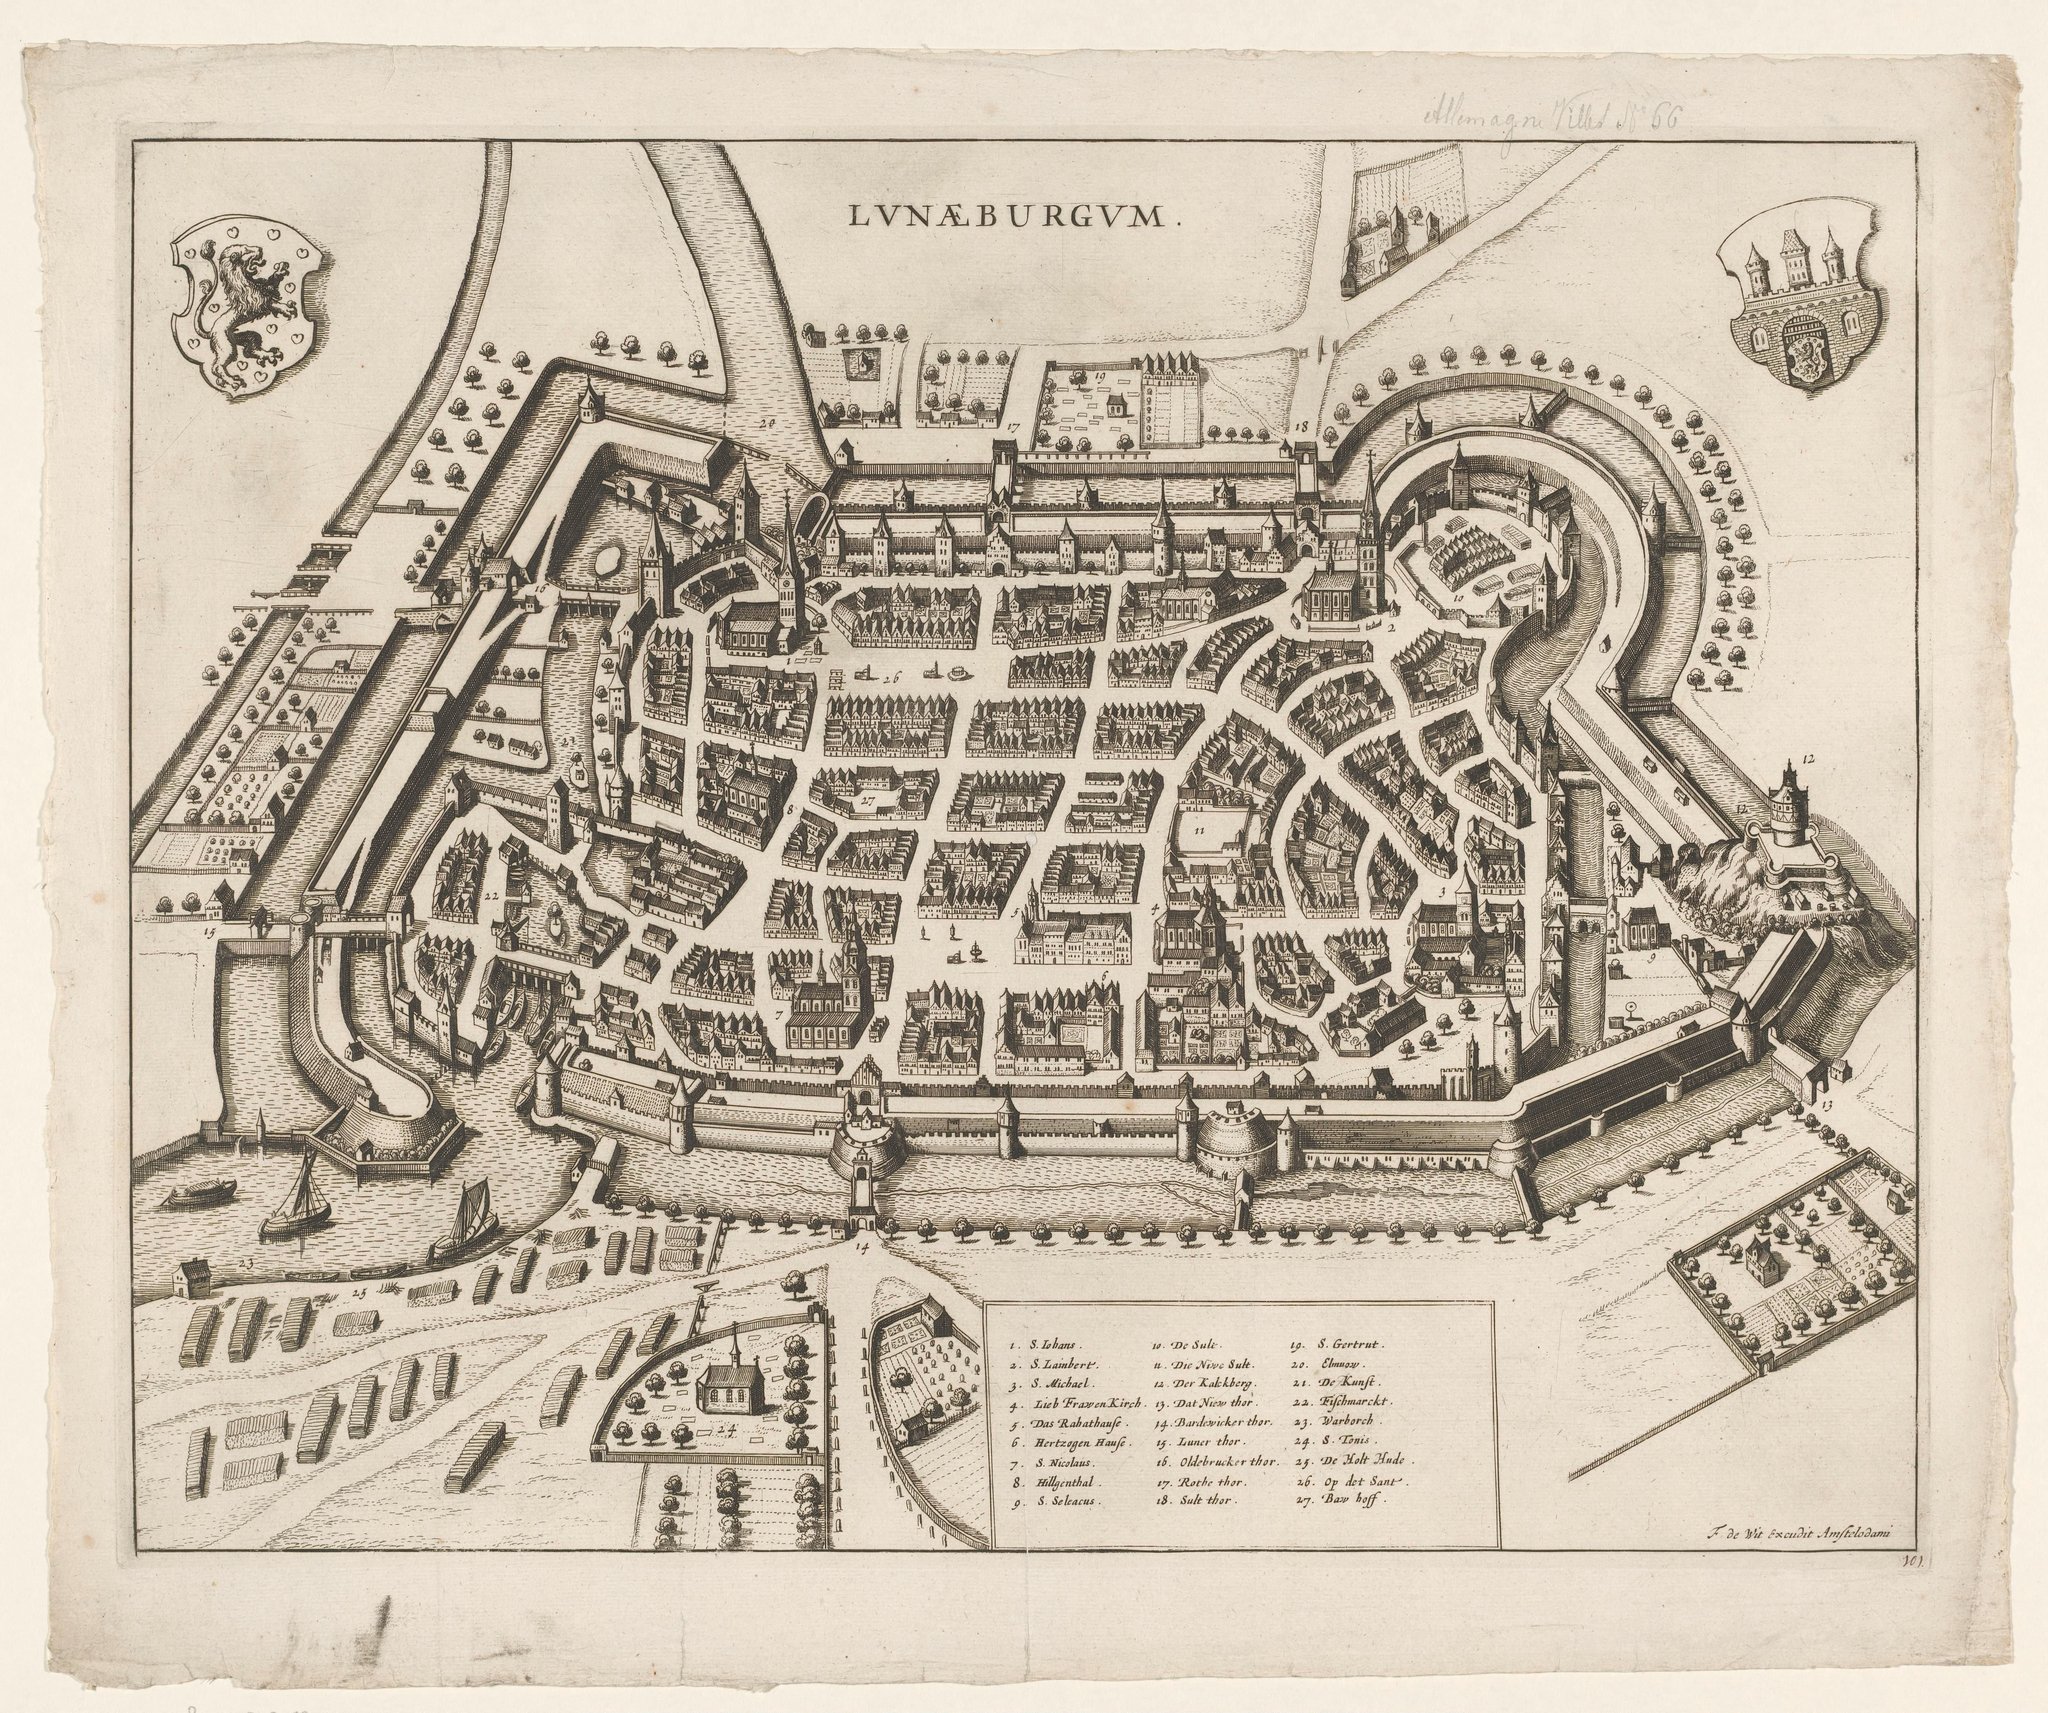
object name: area plan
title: Lunaeburgum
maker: Anonymous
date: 1657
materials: paper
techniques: engraving, etching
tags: coat of arms (as symbol of the state, etc.) (+ city; municipal), coat of arms (as symbol of the state, etc.) (+ province; provincial), prospect of city, town panorama, silhouette of city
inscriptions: collector's mark: Lugt 2228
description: Gezicht op Lüneburg in vogelvluchtperspectief. Linksboven het wapen van het prinsdom Lüneburg, rechtsboven van de stad Lüneburg.